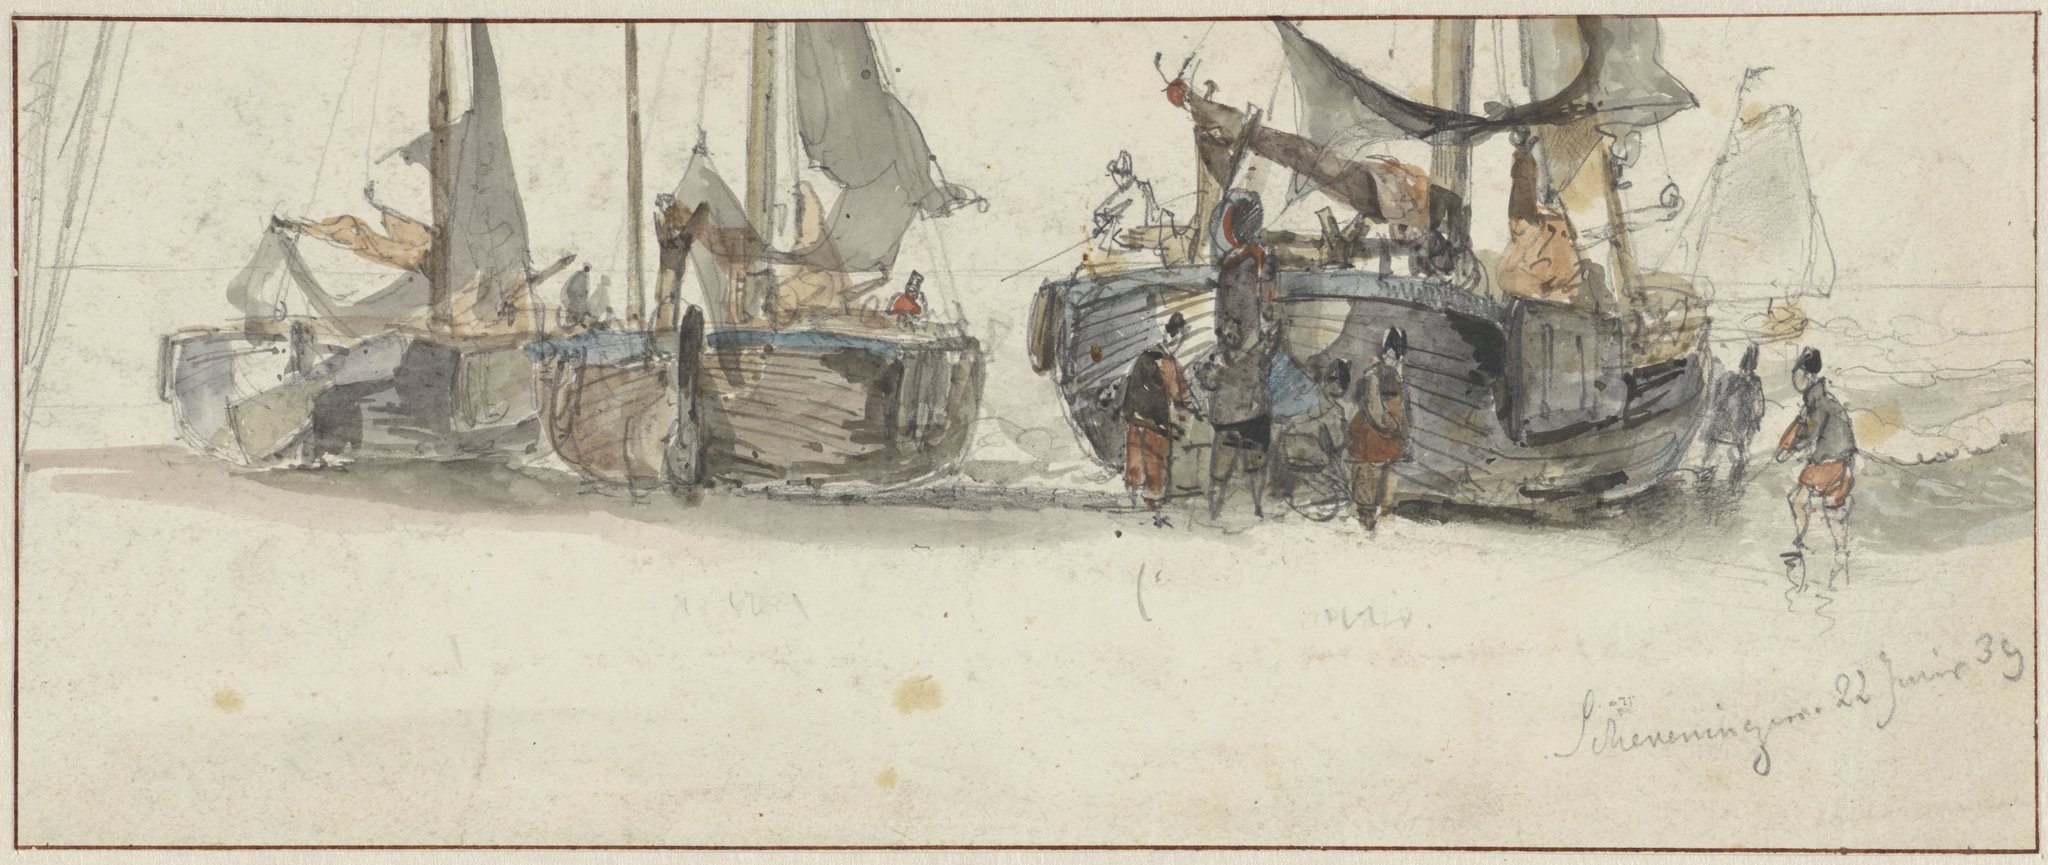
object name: watercolor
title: Vissersboten op het strand van Scheveningen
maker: willem roelofs (i)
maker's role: draughtsman, painter, print maker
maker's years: 1822-1897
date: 1839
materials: paper, pencil, watercolor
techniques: brush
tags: commercial fishery, ships (in general), beach